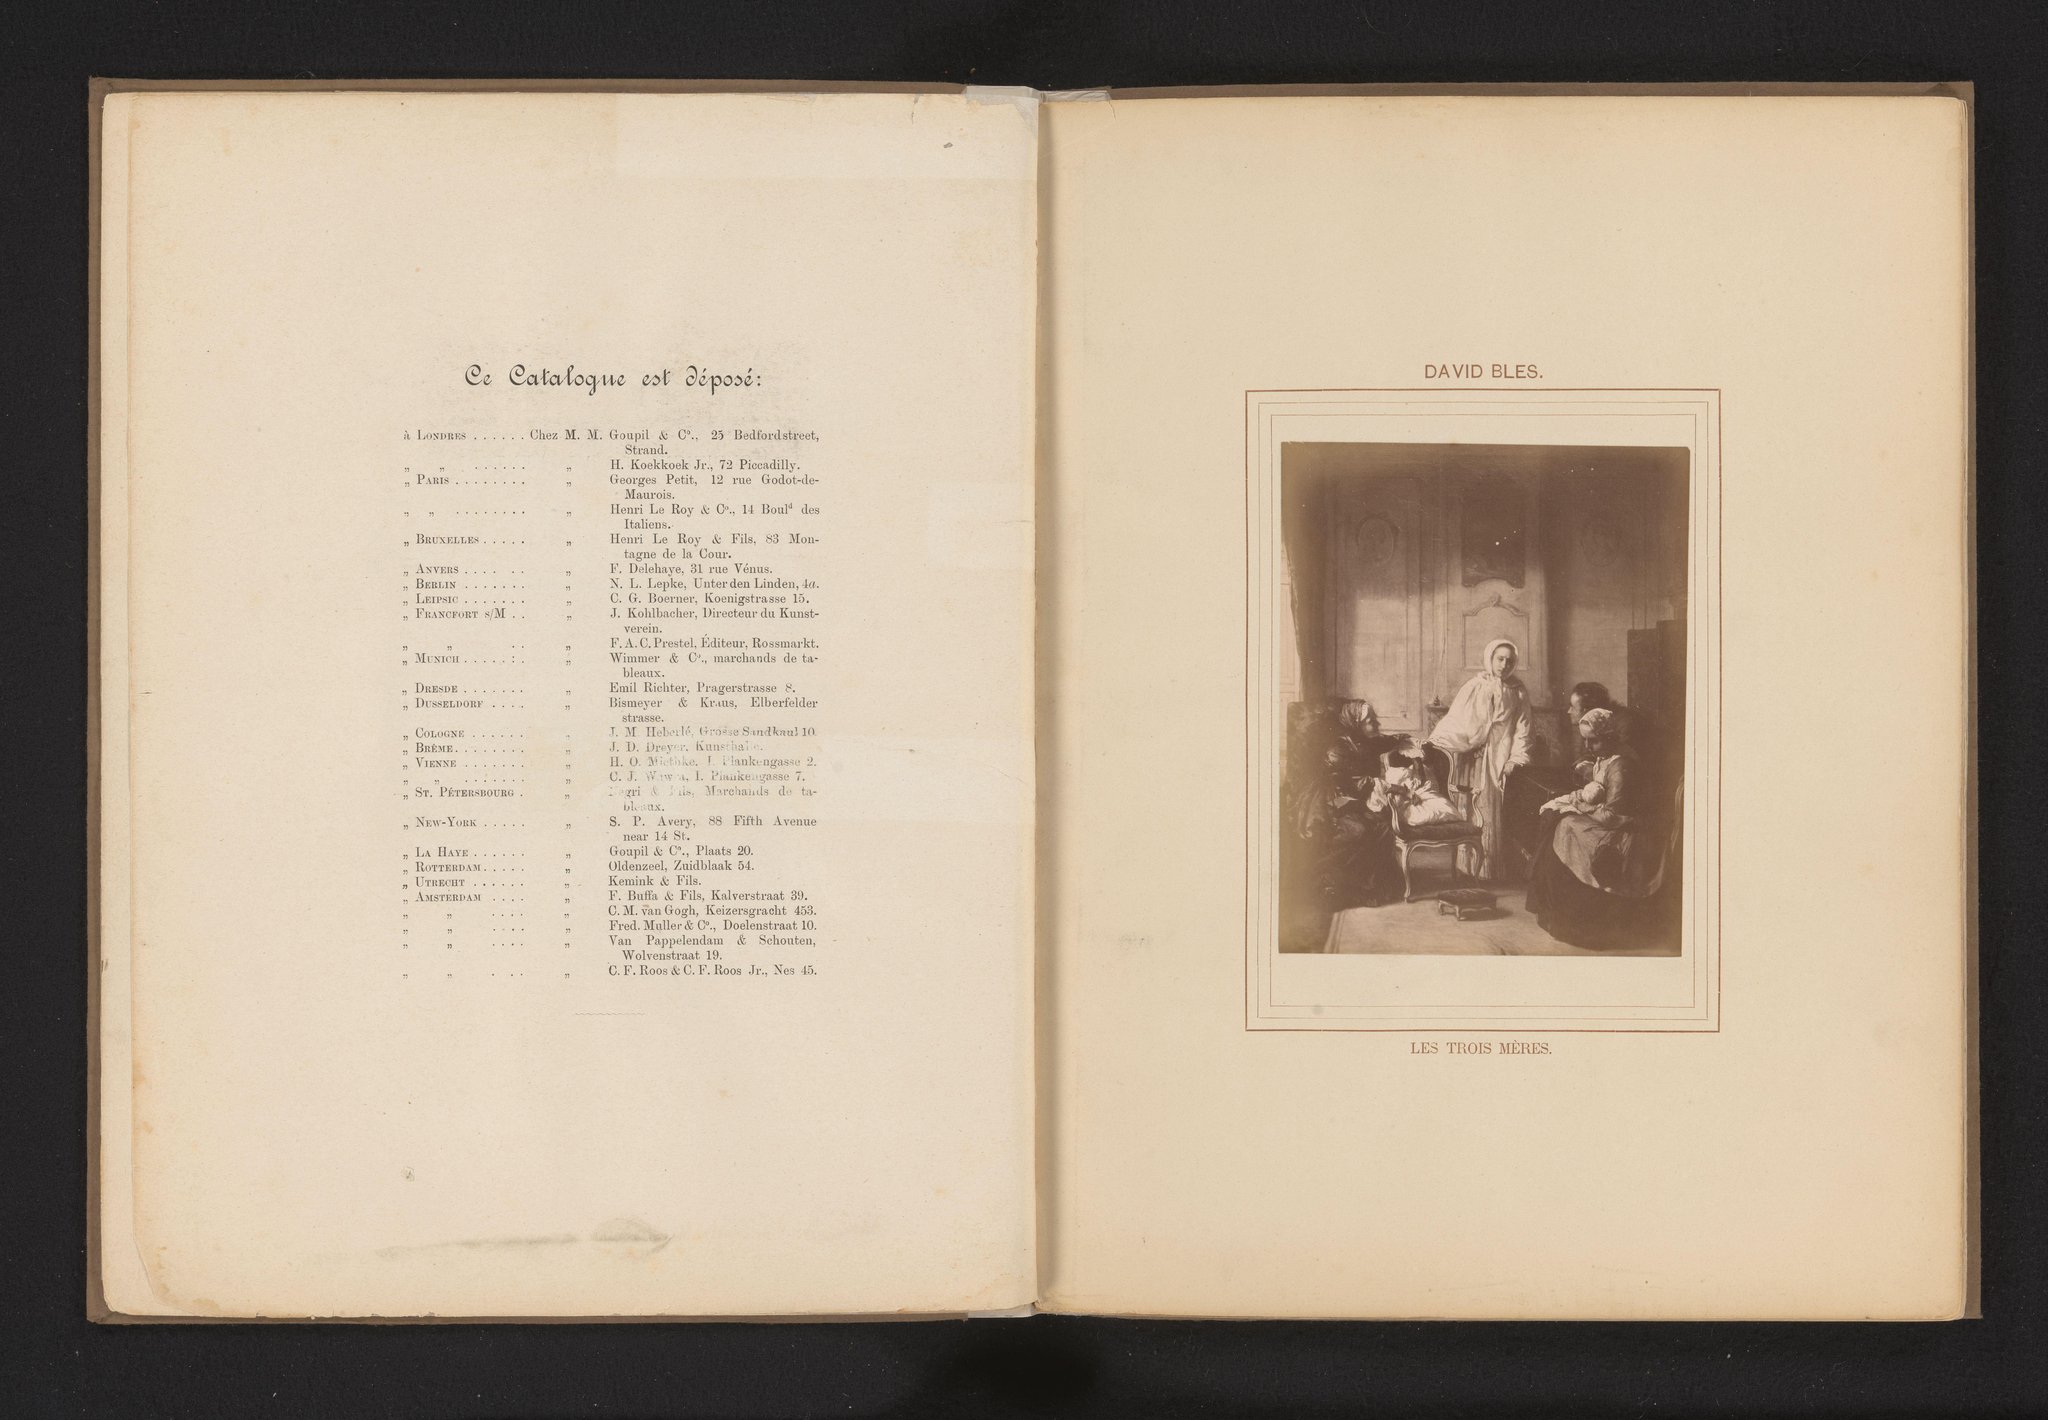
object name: page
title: Les trois mères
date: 1878-1883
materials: paper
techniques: albumen print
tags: painting, drawing and the graphic arts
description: Foto op derde ongenummerde pagina na pagina 10.